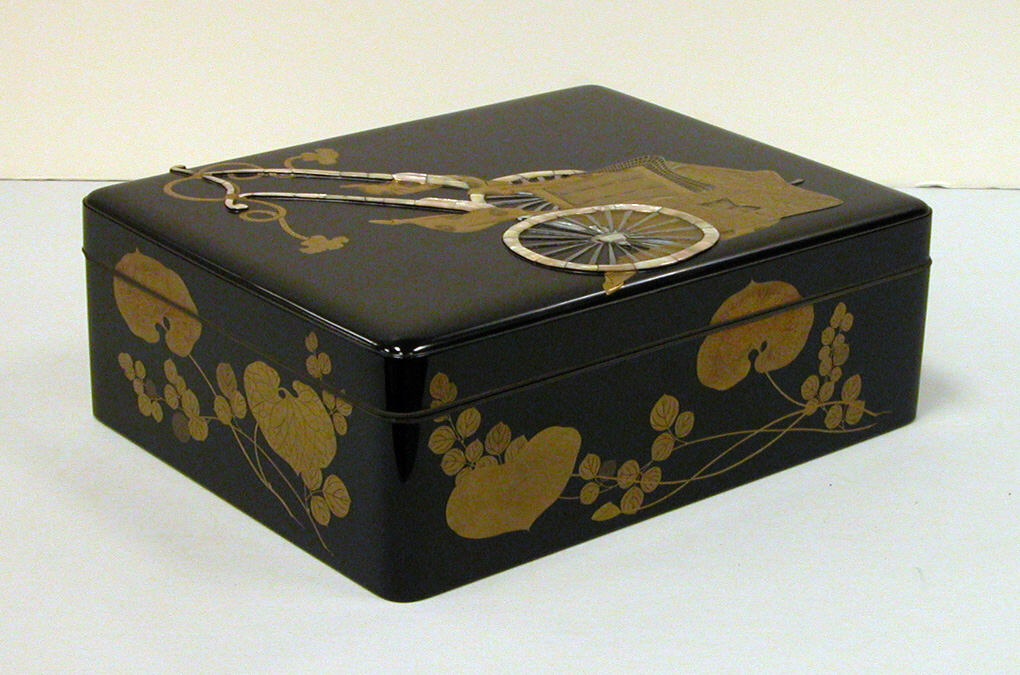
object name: box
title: Document Box (Ryōshibako) with Court Carriage and Wild Ginger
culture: japanese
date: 1767-1833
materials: gold, pearl, silver, wood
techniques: hiramakie, inlay, lacquer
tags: plants,carriages